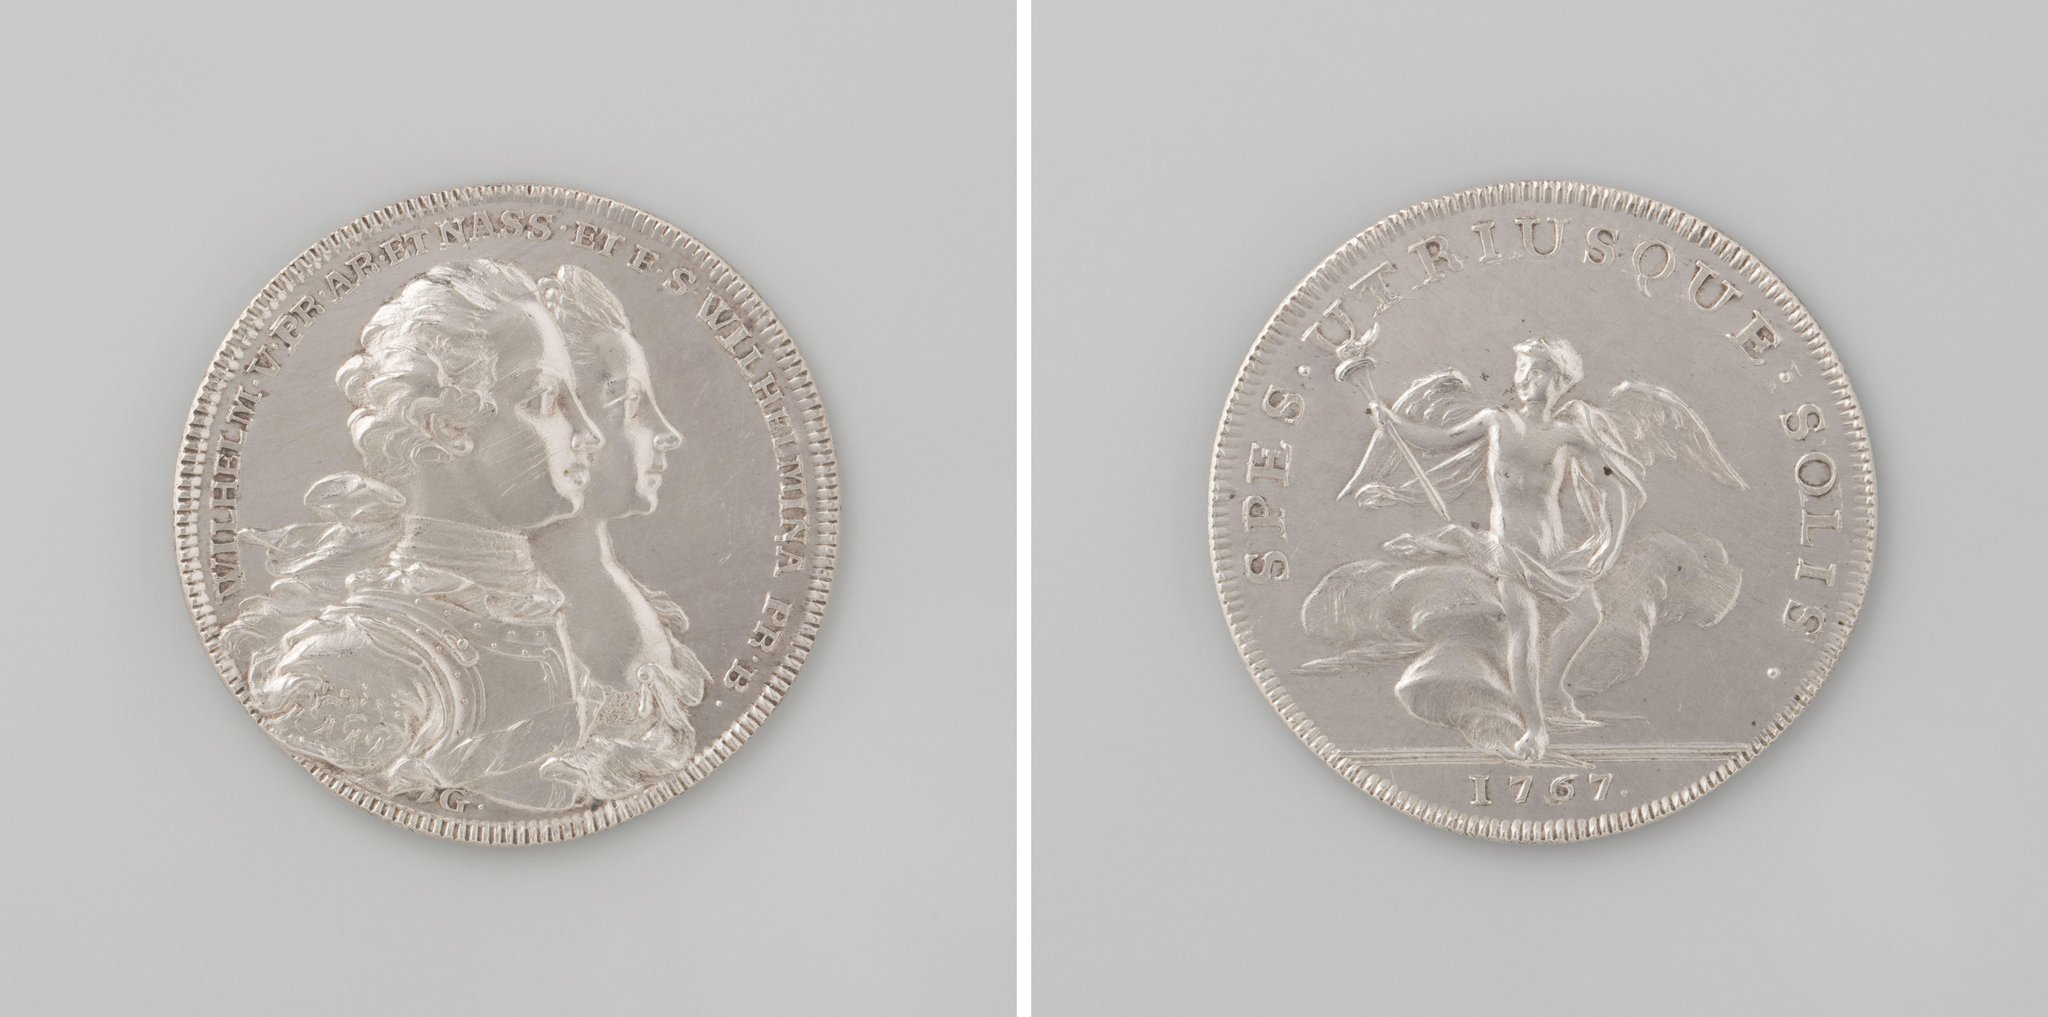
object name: history medal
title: Huwelijk van Willem V met Wilhelmina Frederica Sophia van Pruisen te Berlijn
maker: elias gervais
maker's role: die cutter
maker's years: 1721-1791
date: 1767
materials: silver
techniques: striking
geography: germany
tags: the hague, william v (prince of orange), berlin, painter, draughtsman, wilhelmina of prussia (princess of orange)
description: Zilveren penning. Voorzijde: borststuk man en vrouw binnen omschrift. Keerzijde: huwelijksgod met brandende fakkel in hand daalt af op wolk binnen omschrift; afsnede: jaartal